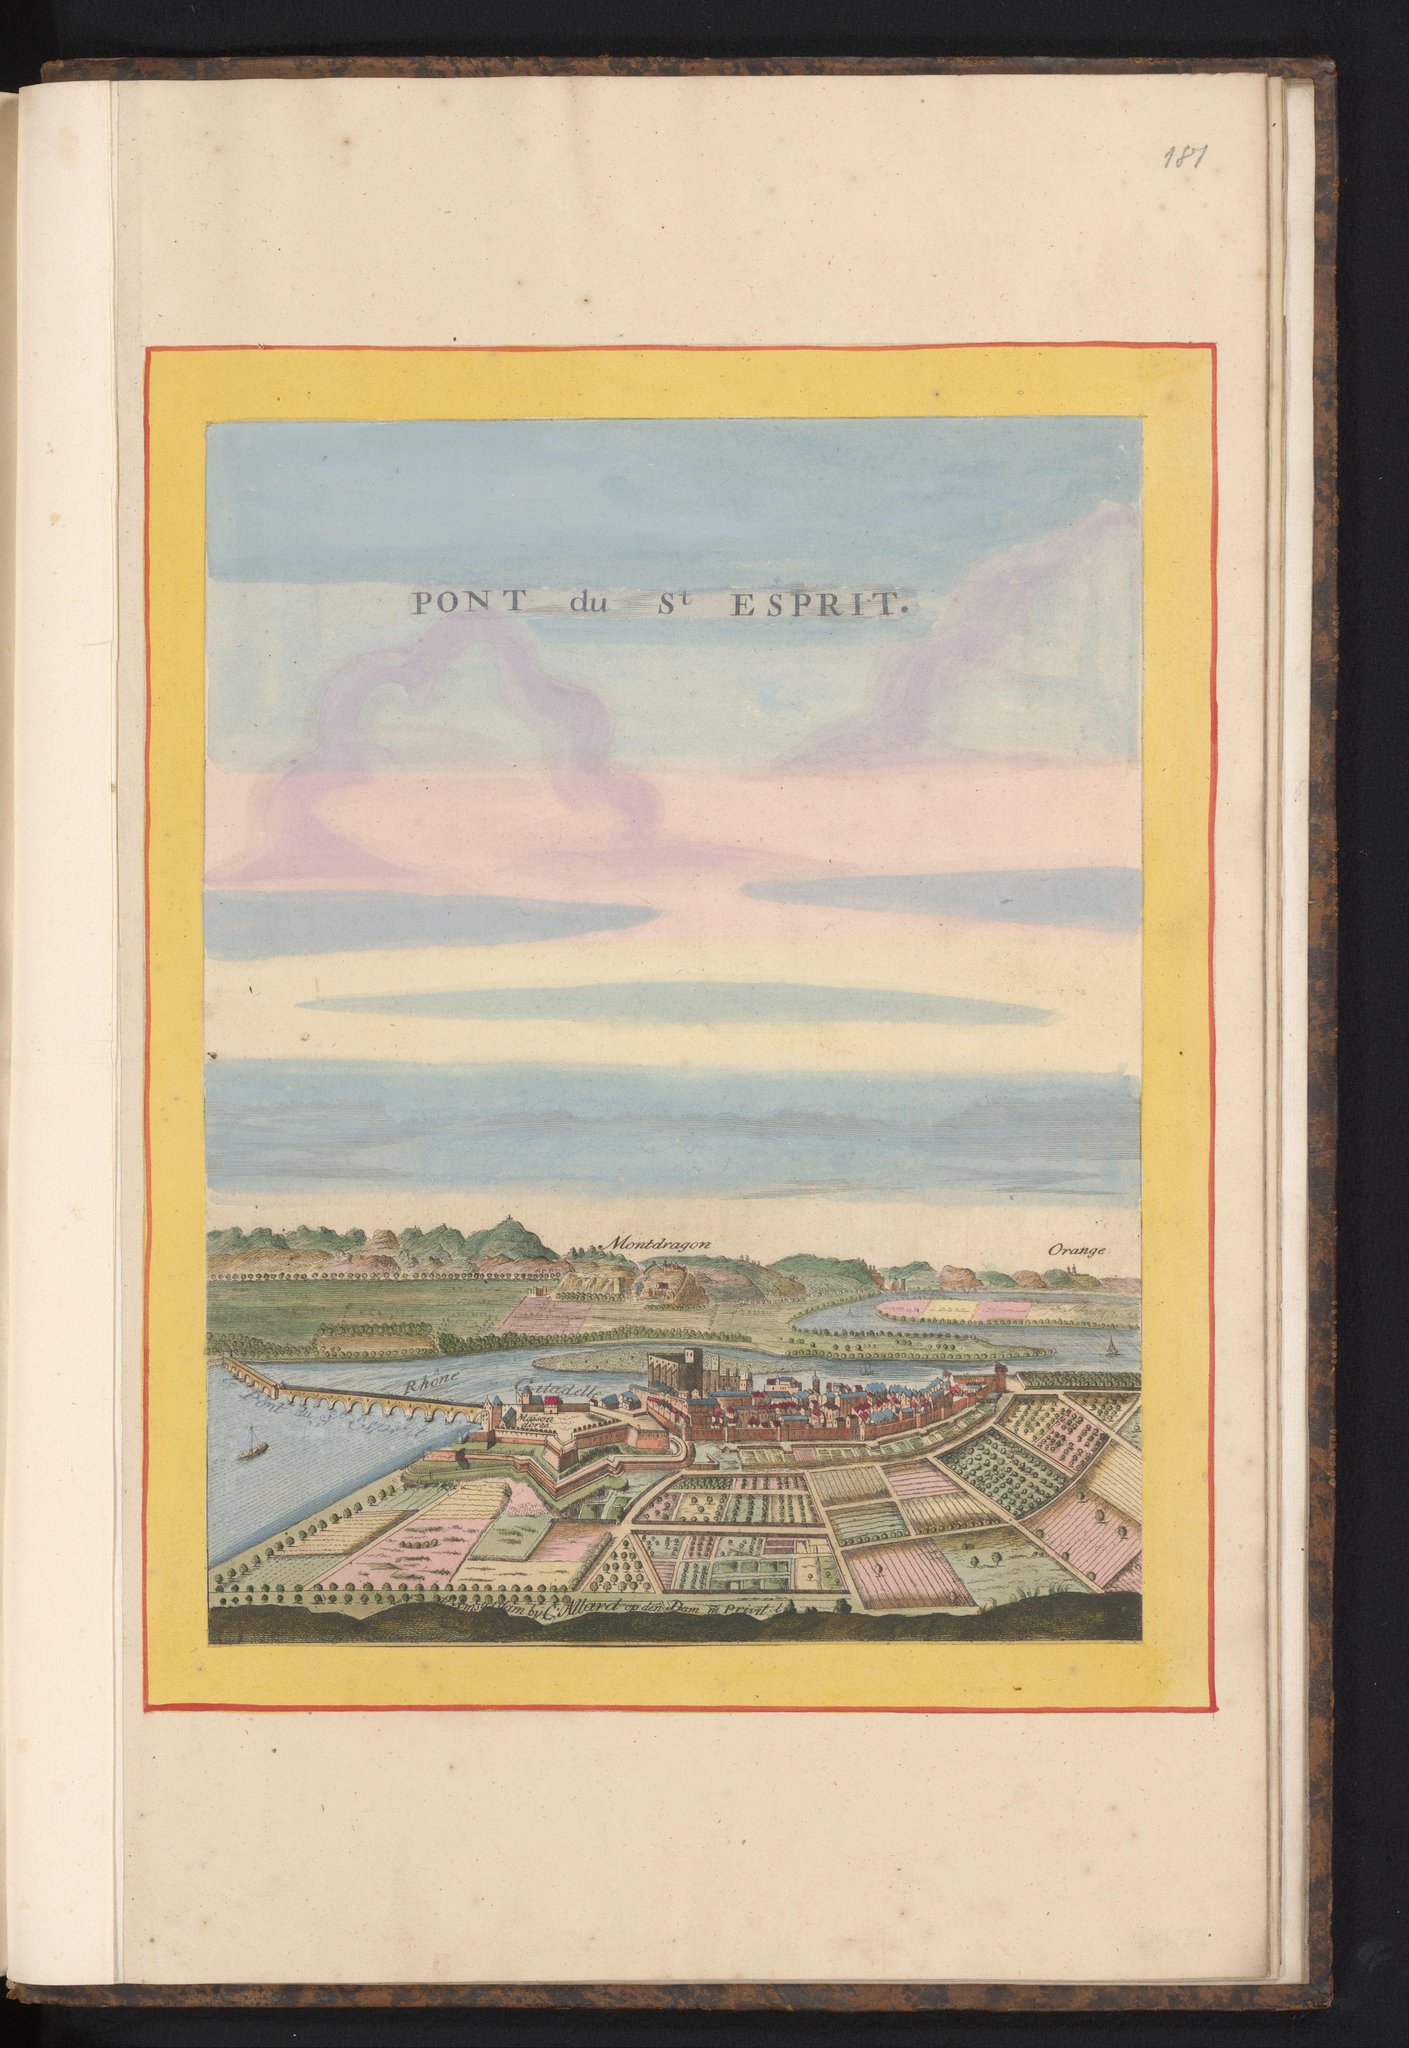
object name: album leaf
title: Pont du St. Esprit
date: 1713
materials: paper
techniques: engraving, hand coloring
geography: the hague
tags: city-view in general; 'veduta'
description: Prent uit: Allard, Abraham. Les principales forteresses & villes fortes, d'Espagne, de France, d'Italie, de Savoië, d'Allemagne & des Païs-Bas (...). Amsterdam: Pieter van der Aa, 1713.